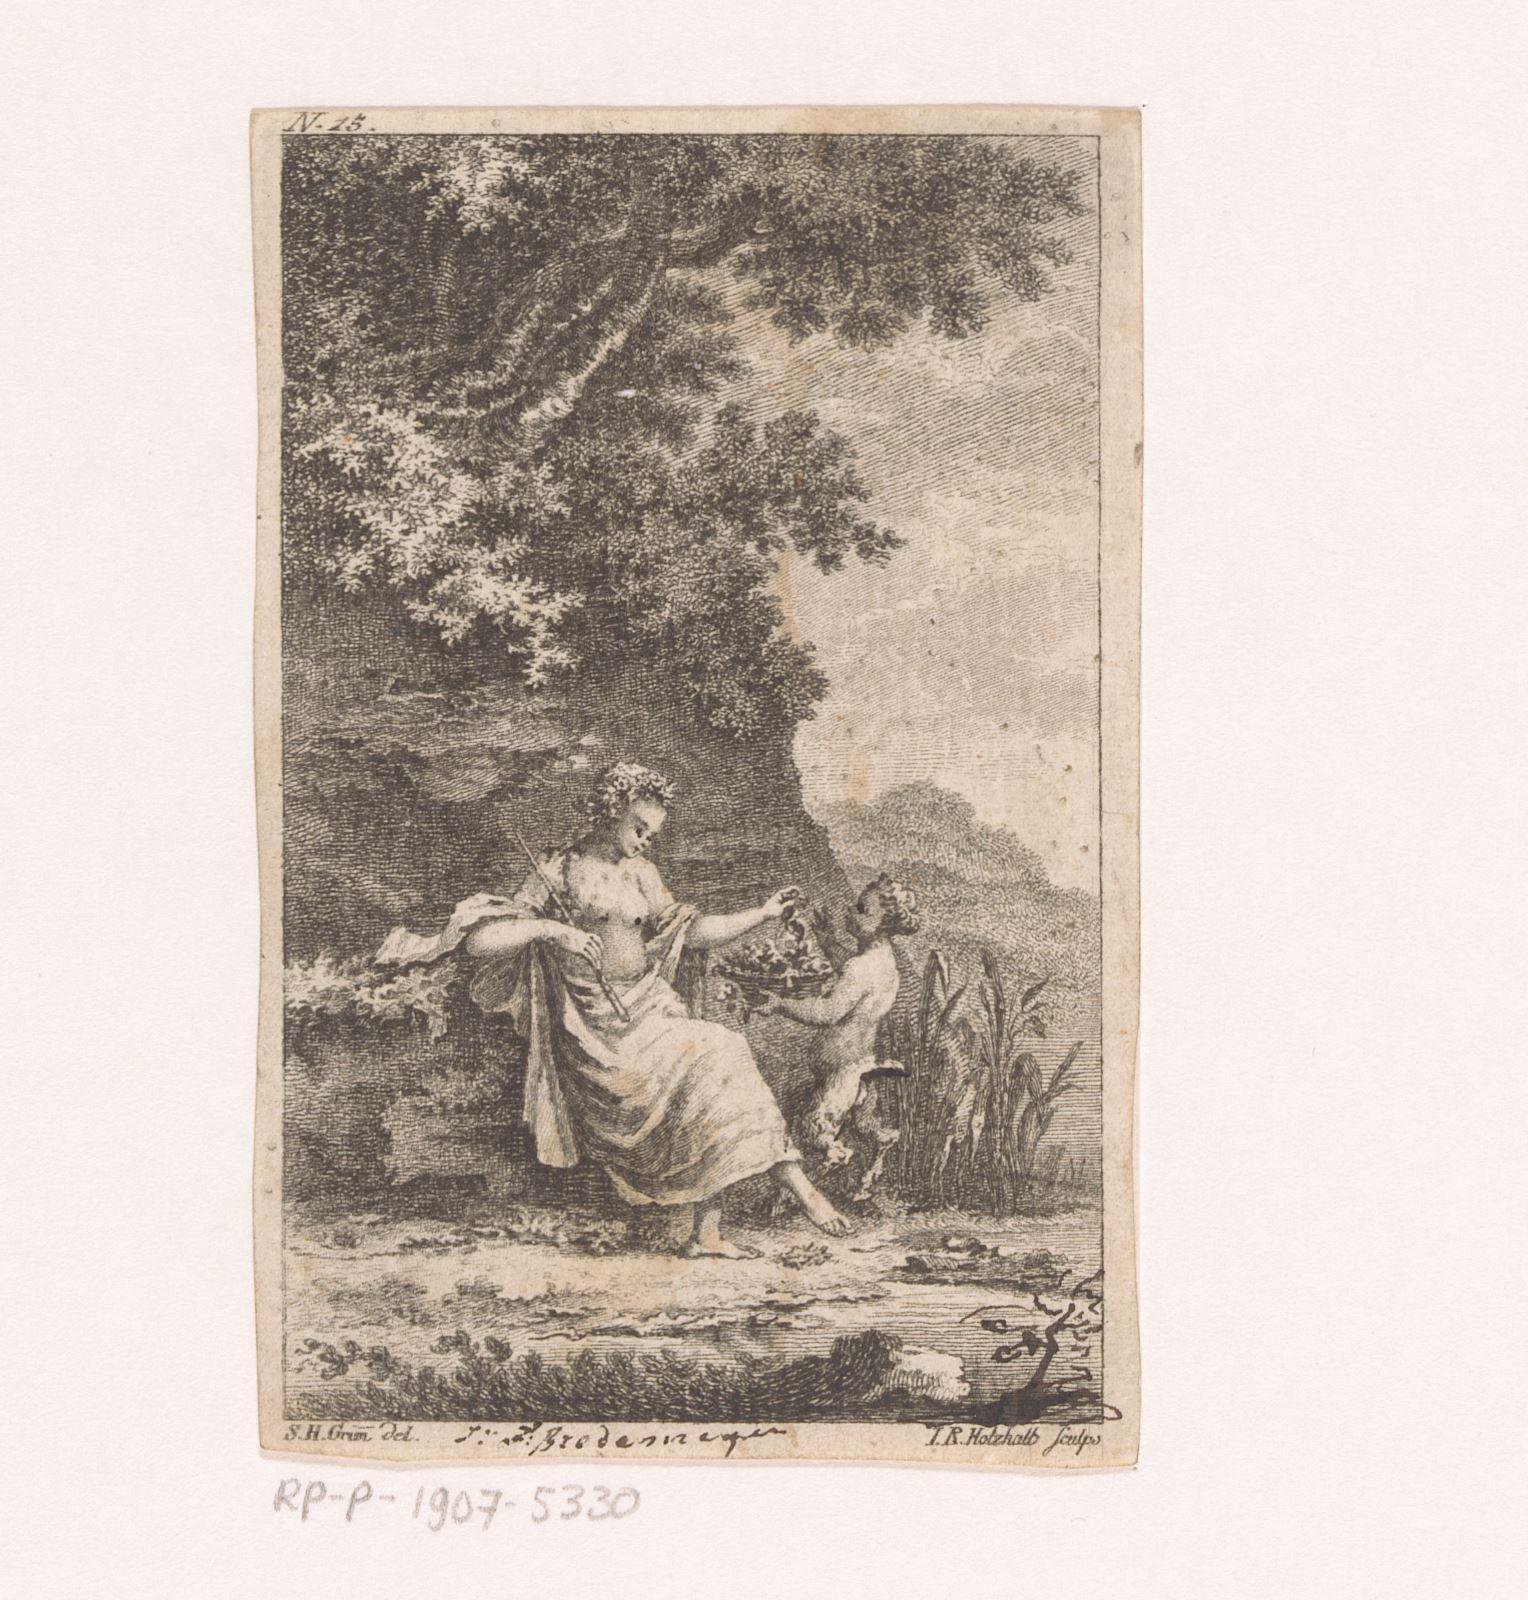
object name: print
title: Bacchante en jonge faun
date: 1733-1806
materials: paper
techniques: etching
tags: satyrs, fauns, sileni, maenad(s), female bacchant(es)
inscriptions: annotation, collector's mark: Lugt 2228, annotation: ‘Z Bredes [...]’